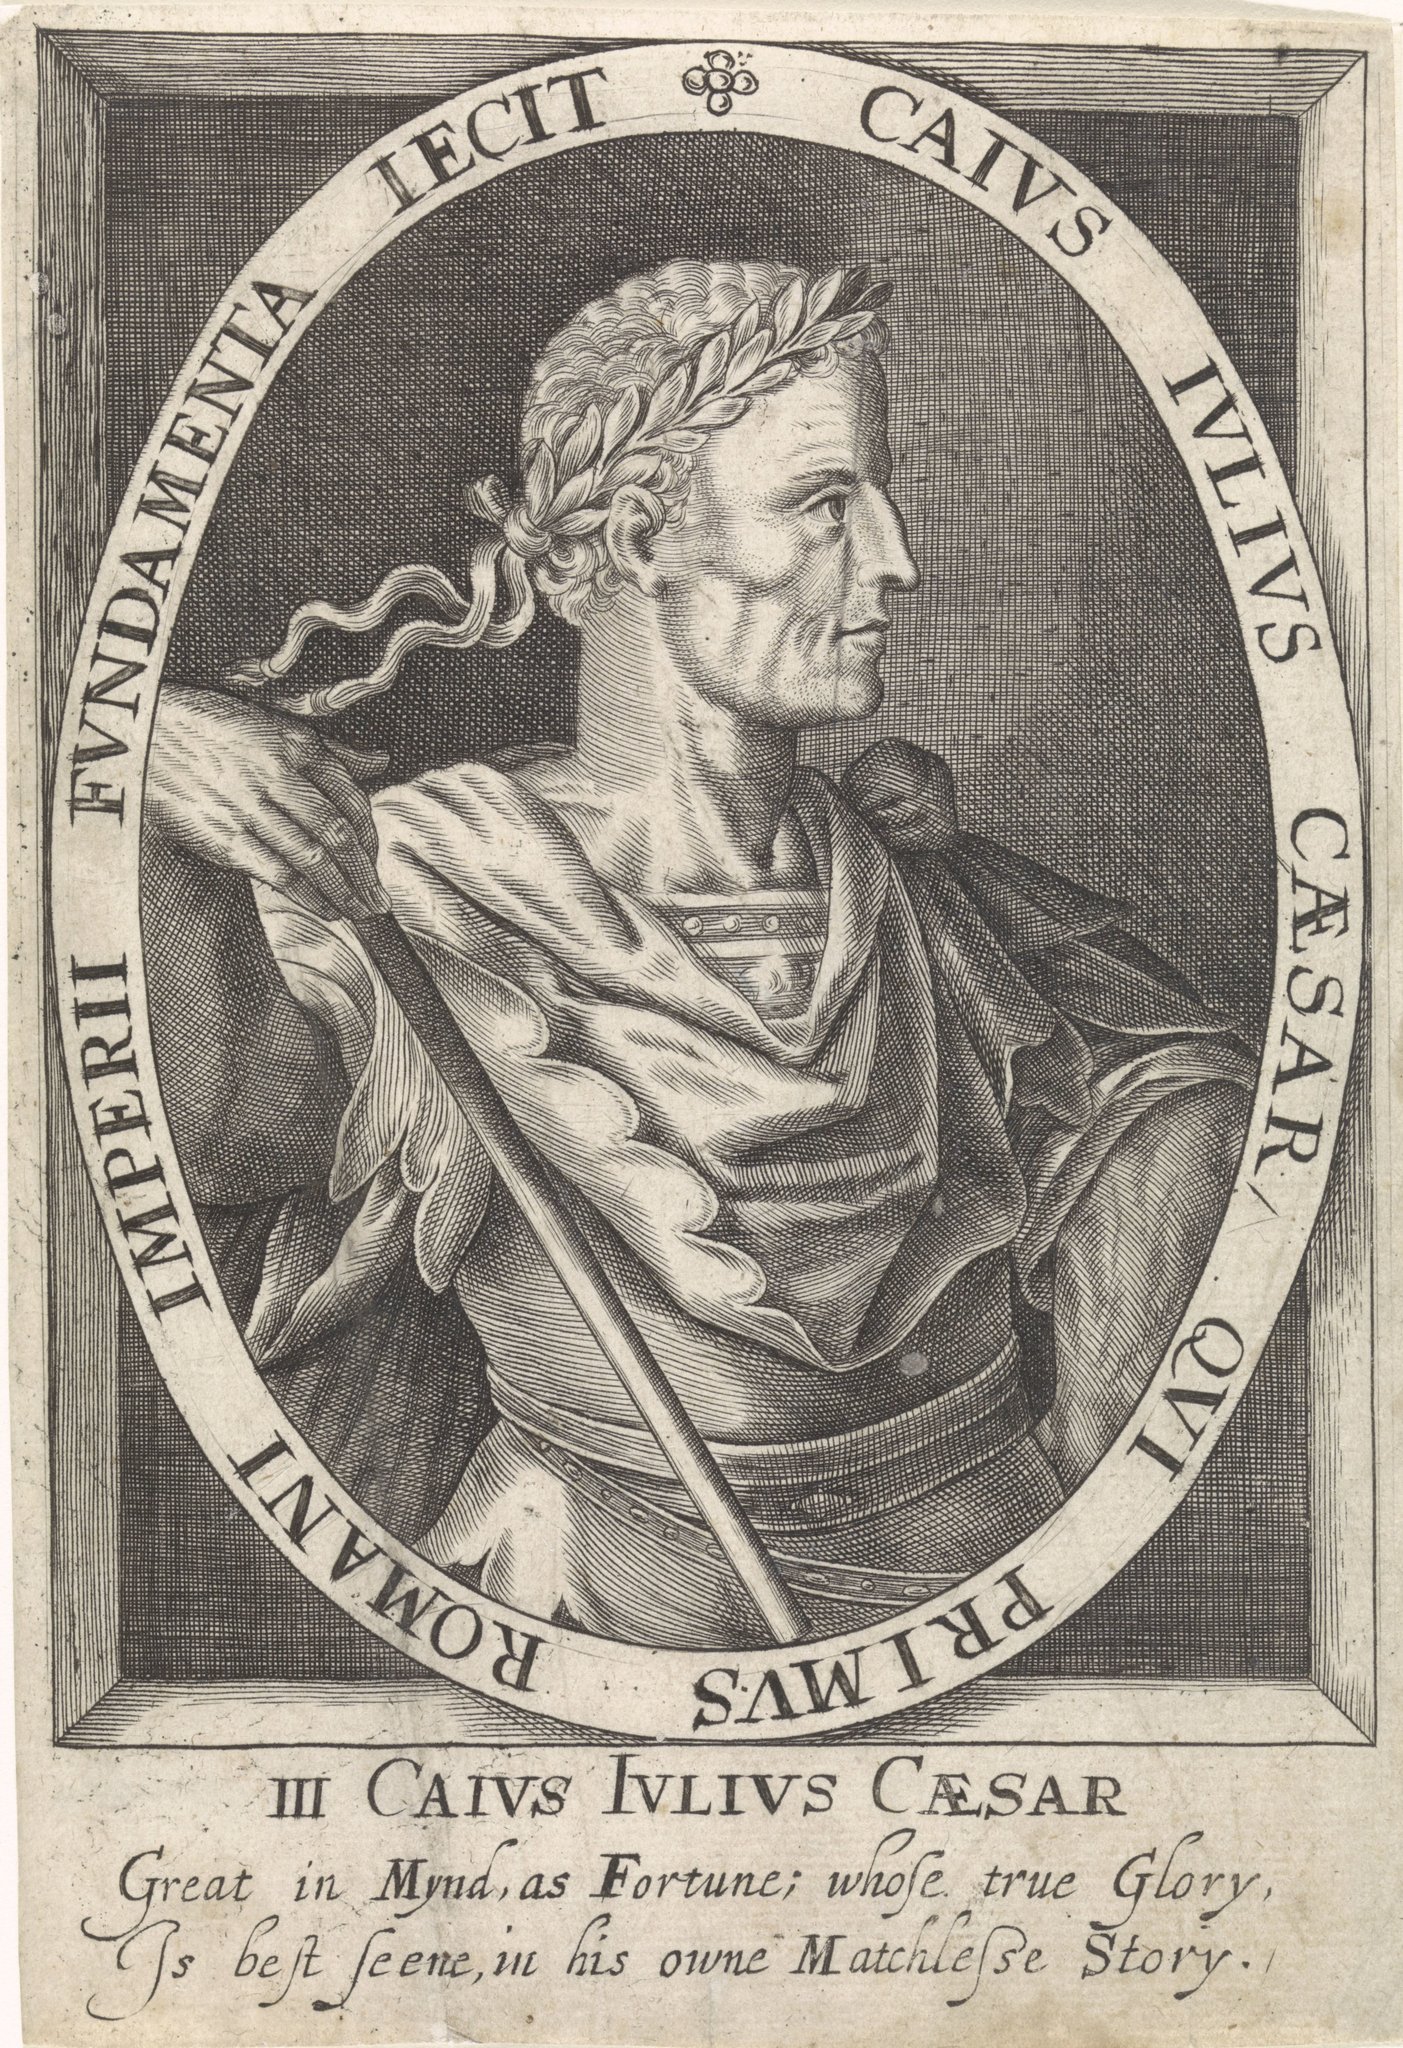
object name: print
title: Julius Caesar als een van de negen helden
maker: willem van de passe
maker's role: print maker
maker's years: 1597-1637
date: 1621-1636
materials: paper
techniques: engraving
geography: london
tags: julius caesar (one of the nine worthies)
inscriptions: collector's mark: Lugt 2228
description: De held uit de klassieke oudheid Julius Caesar. Buste gevat in een ovale omlijsting met een randschrift in het Latijn. In de marge zijn naam en een tweeregelig lofdicht in het Engels.